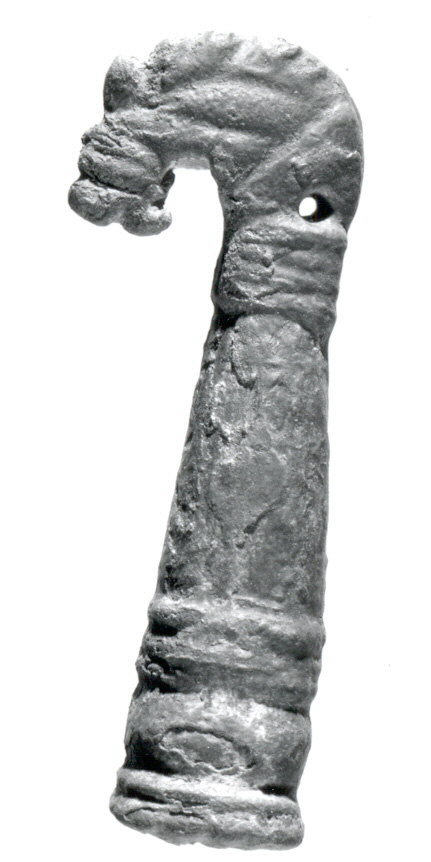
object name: stamp seal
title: Stamp seal (with horse-head handle) with geometric design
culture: iranian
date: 800-601 BCE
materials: iron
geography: iran